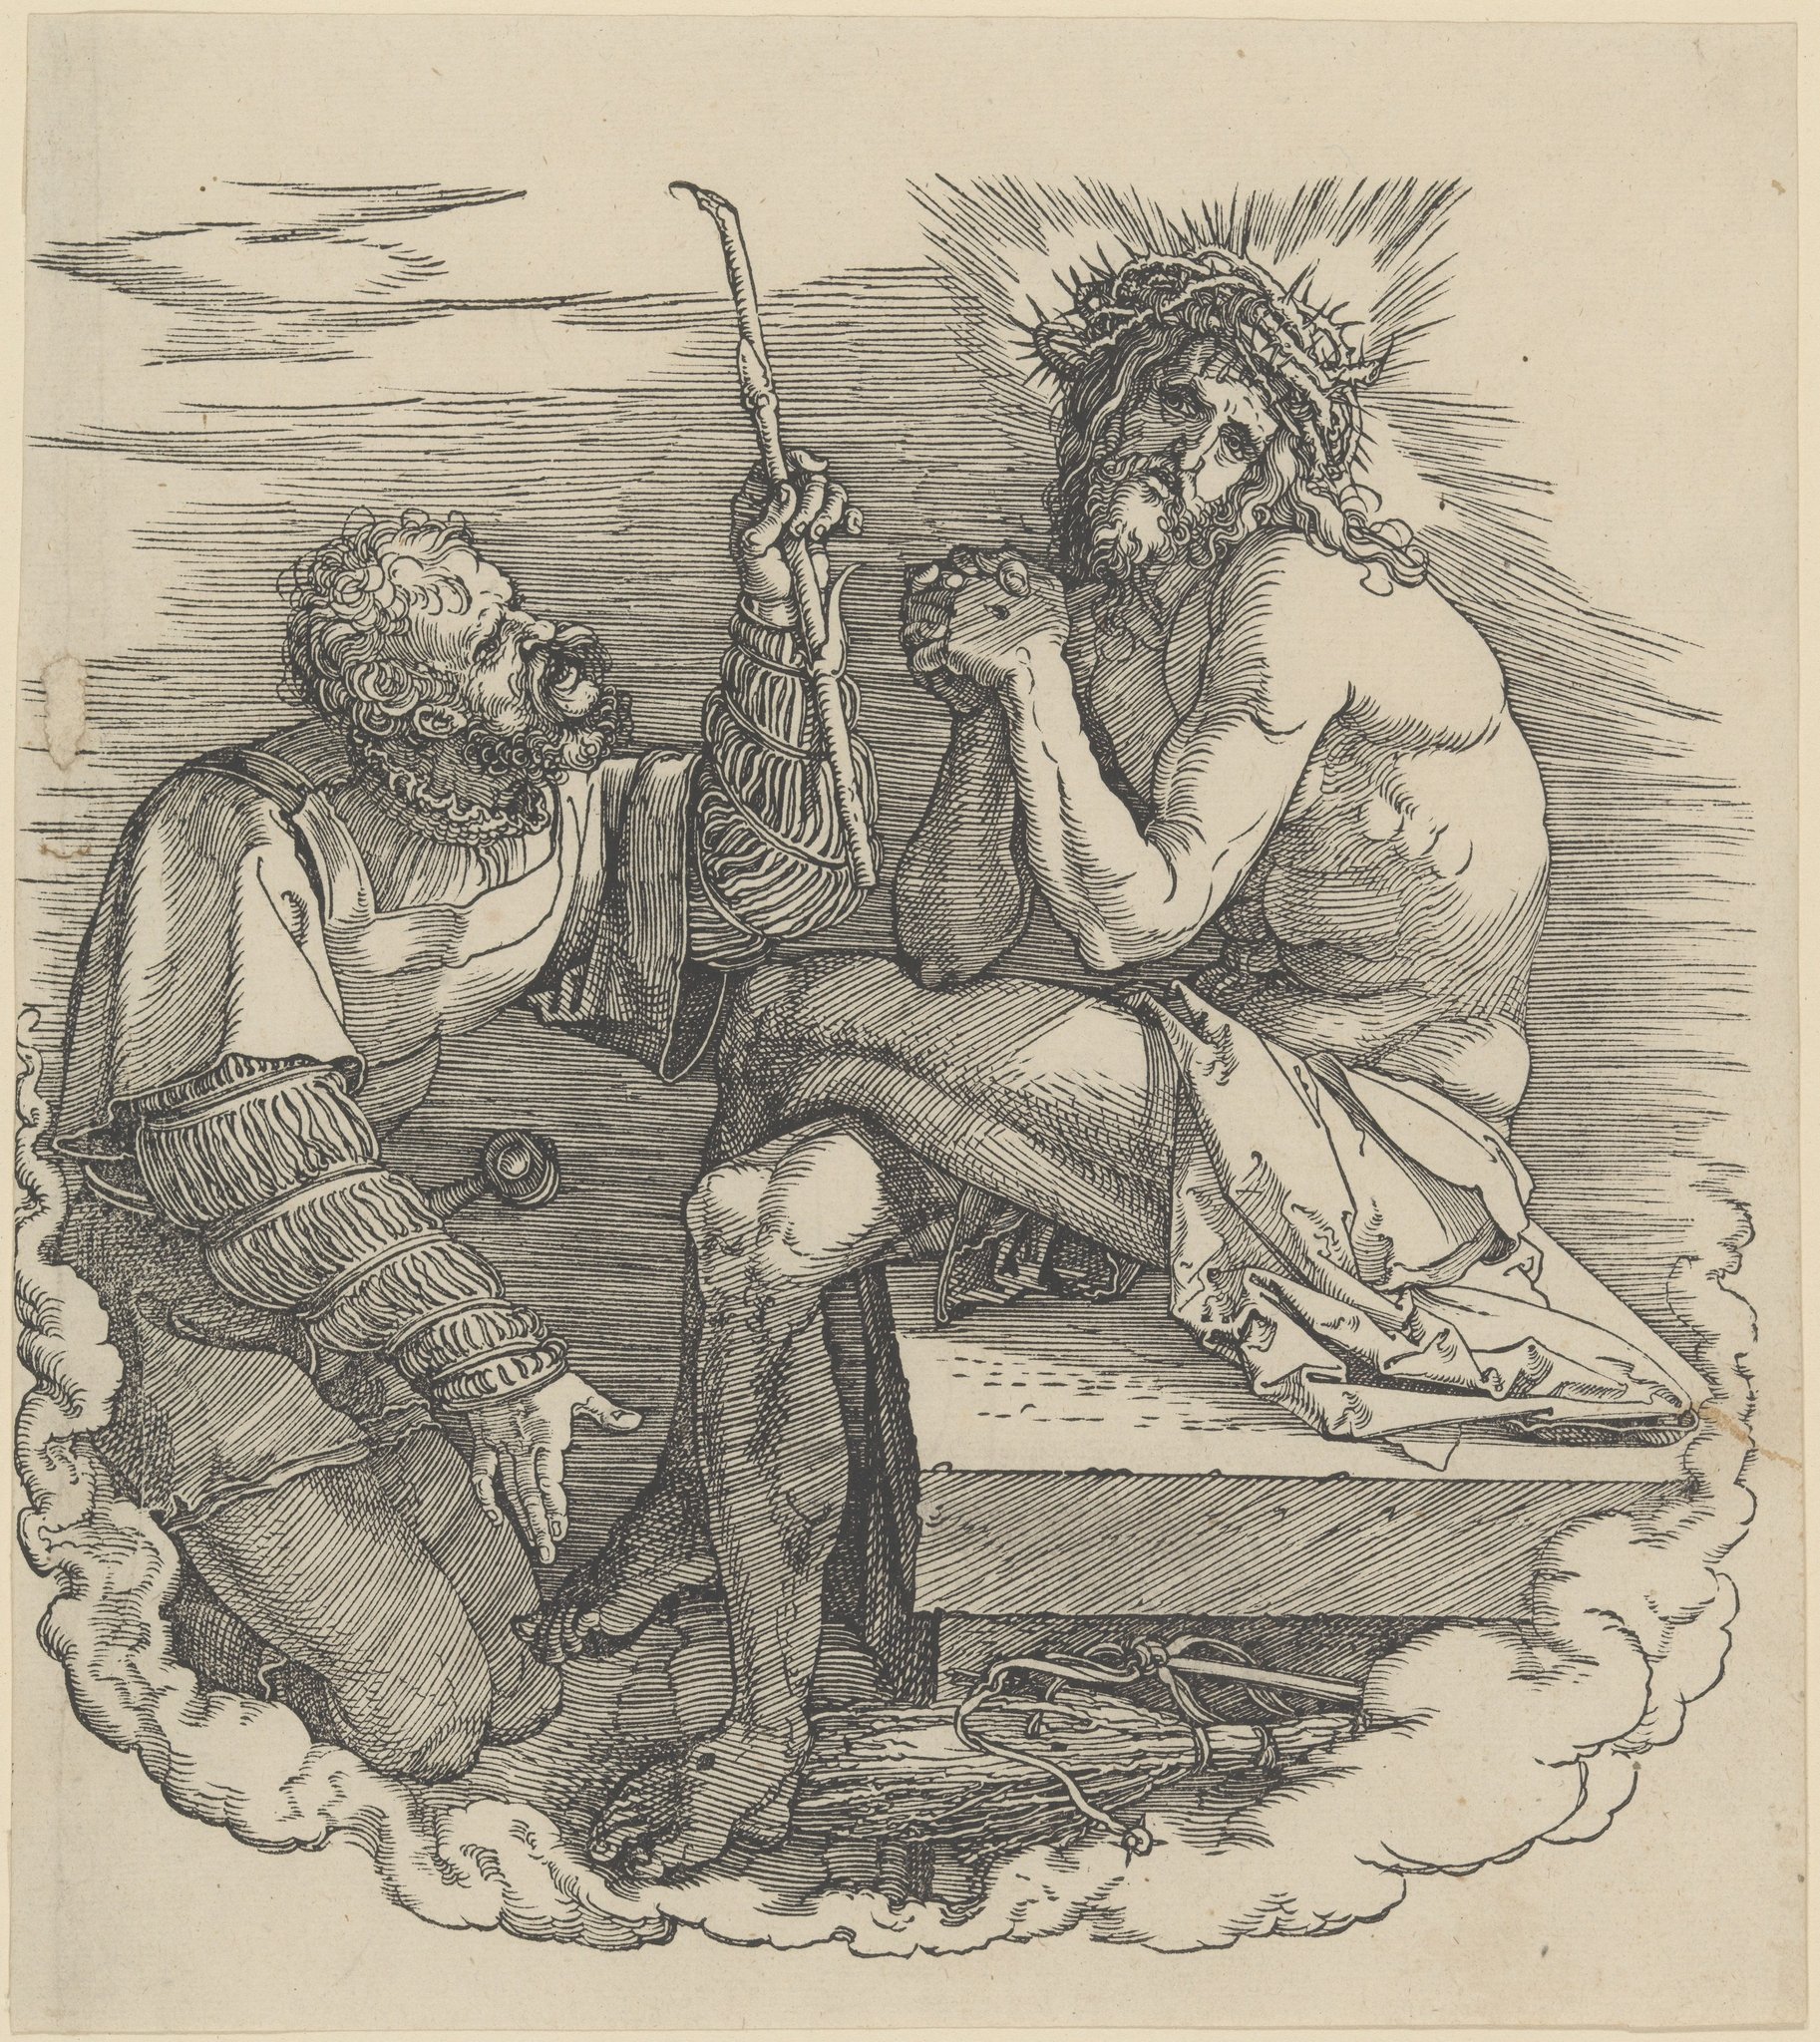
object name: print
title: The Man of Sorrows Mocked by a Soldier, Frontispiece to the Great Passion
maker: albrecht dürer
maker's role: artist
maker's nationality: german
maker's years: 1471-1528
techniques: woodcut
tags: soldiers,christ